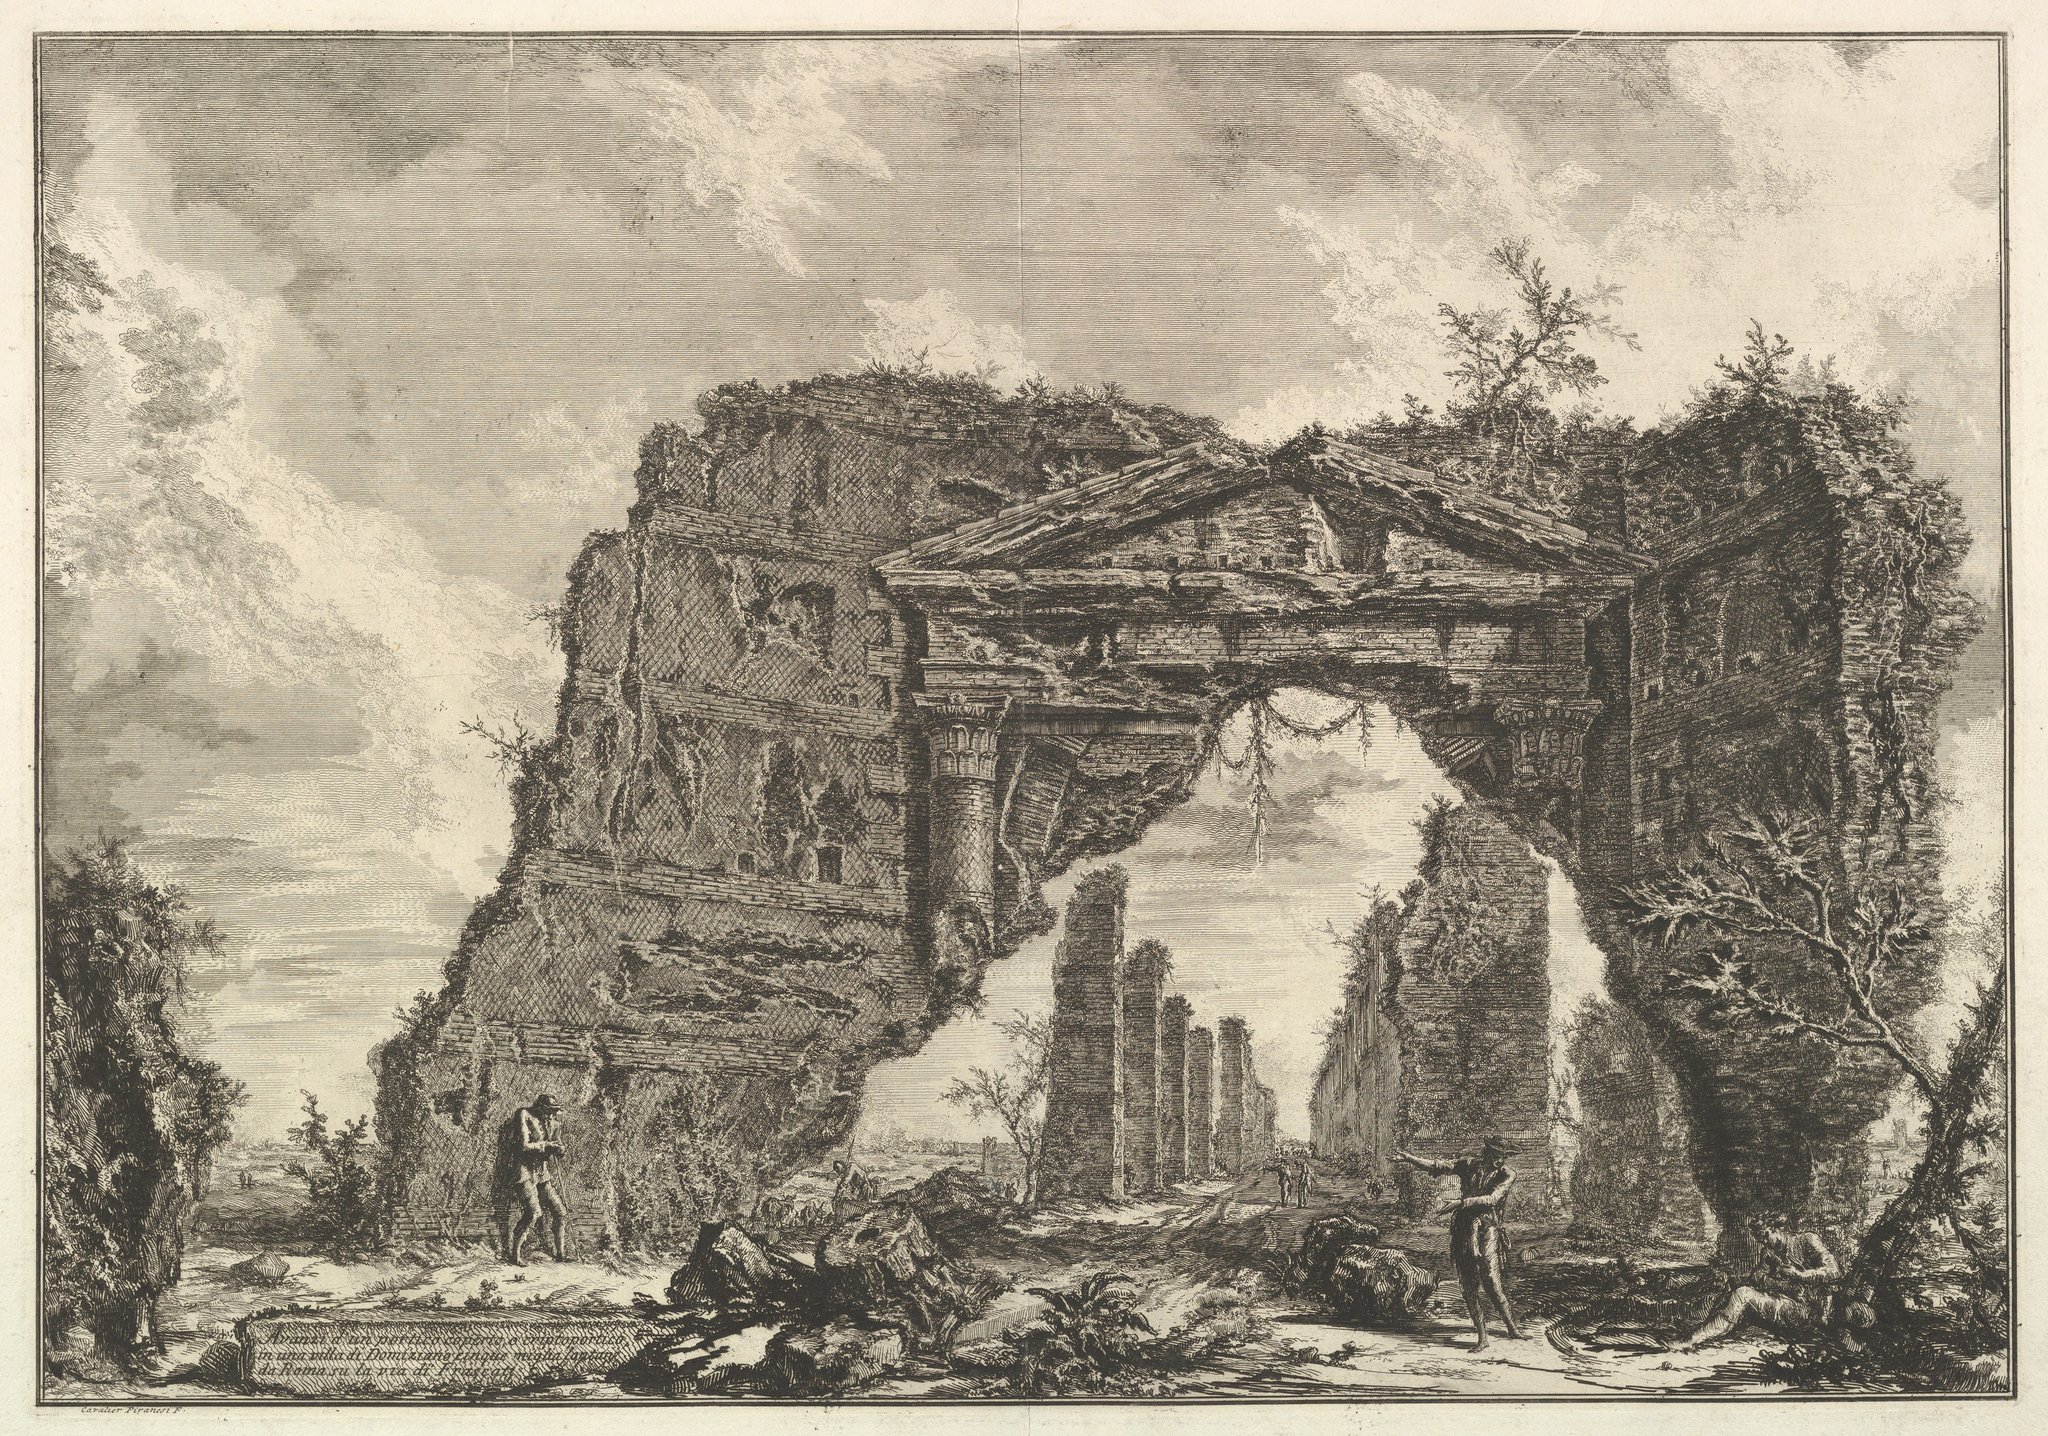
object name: print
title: Remains of a covered portico, or a cryptoportiucus, in a villa of Domitian, five miles outside Rome on the Frascati road, from Vedute di Roma (Roman Views)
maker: giovanni battista piranesi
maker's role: artist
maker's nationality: italian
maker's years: 1720-1778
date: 1766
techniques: etching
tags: human figures,ruins,rome